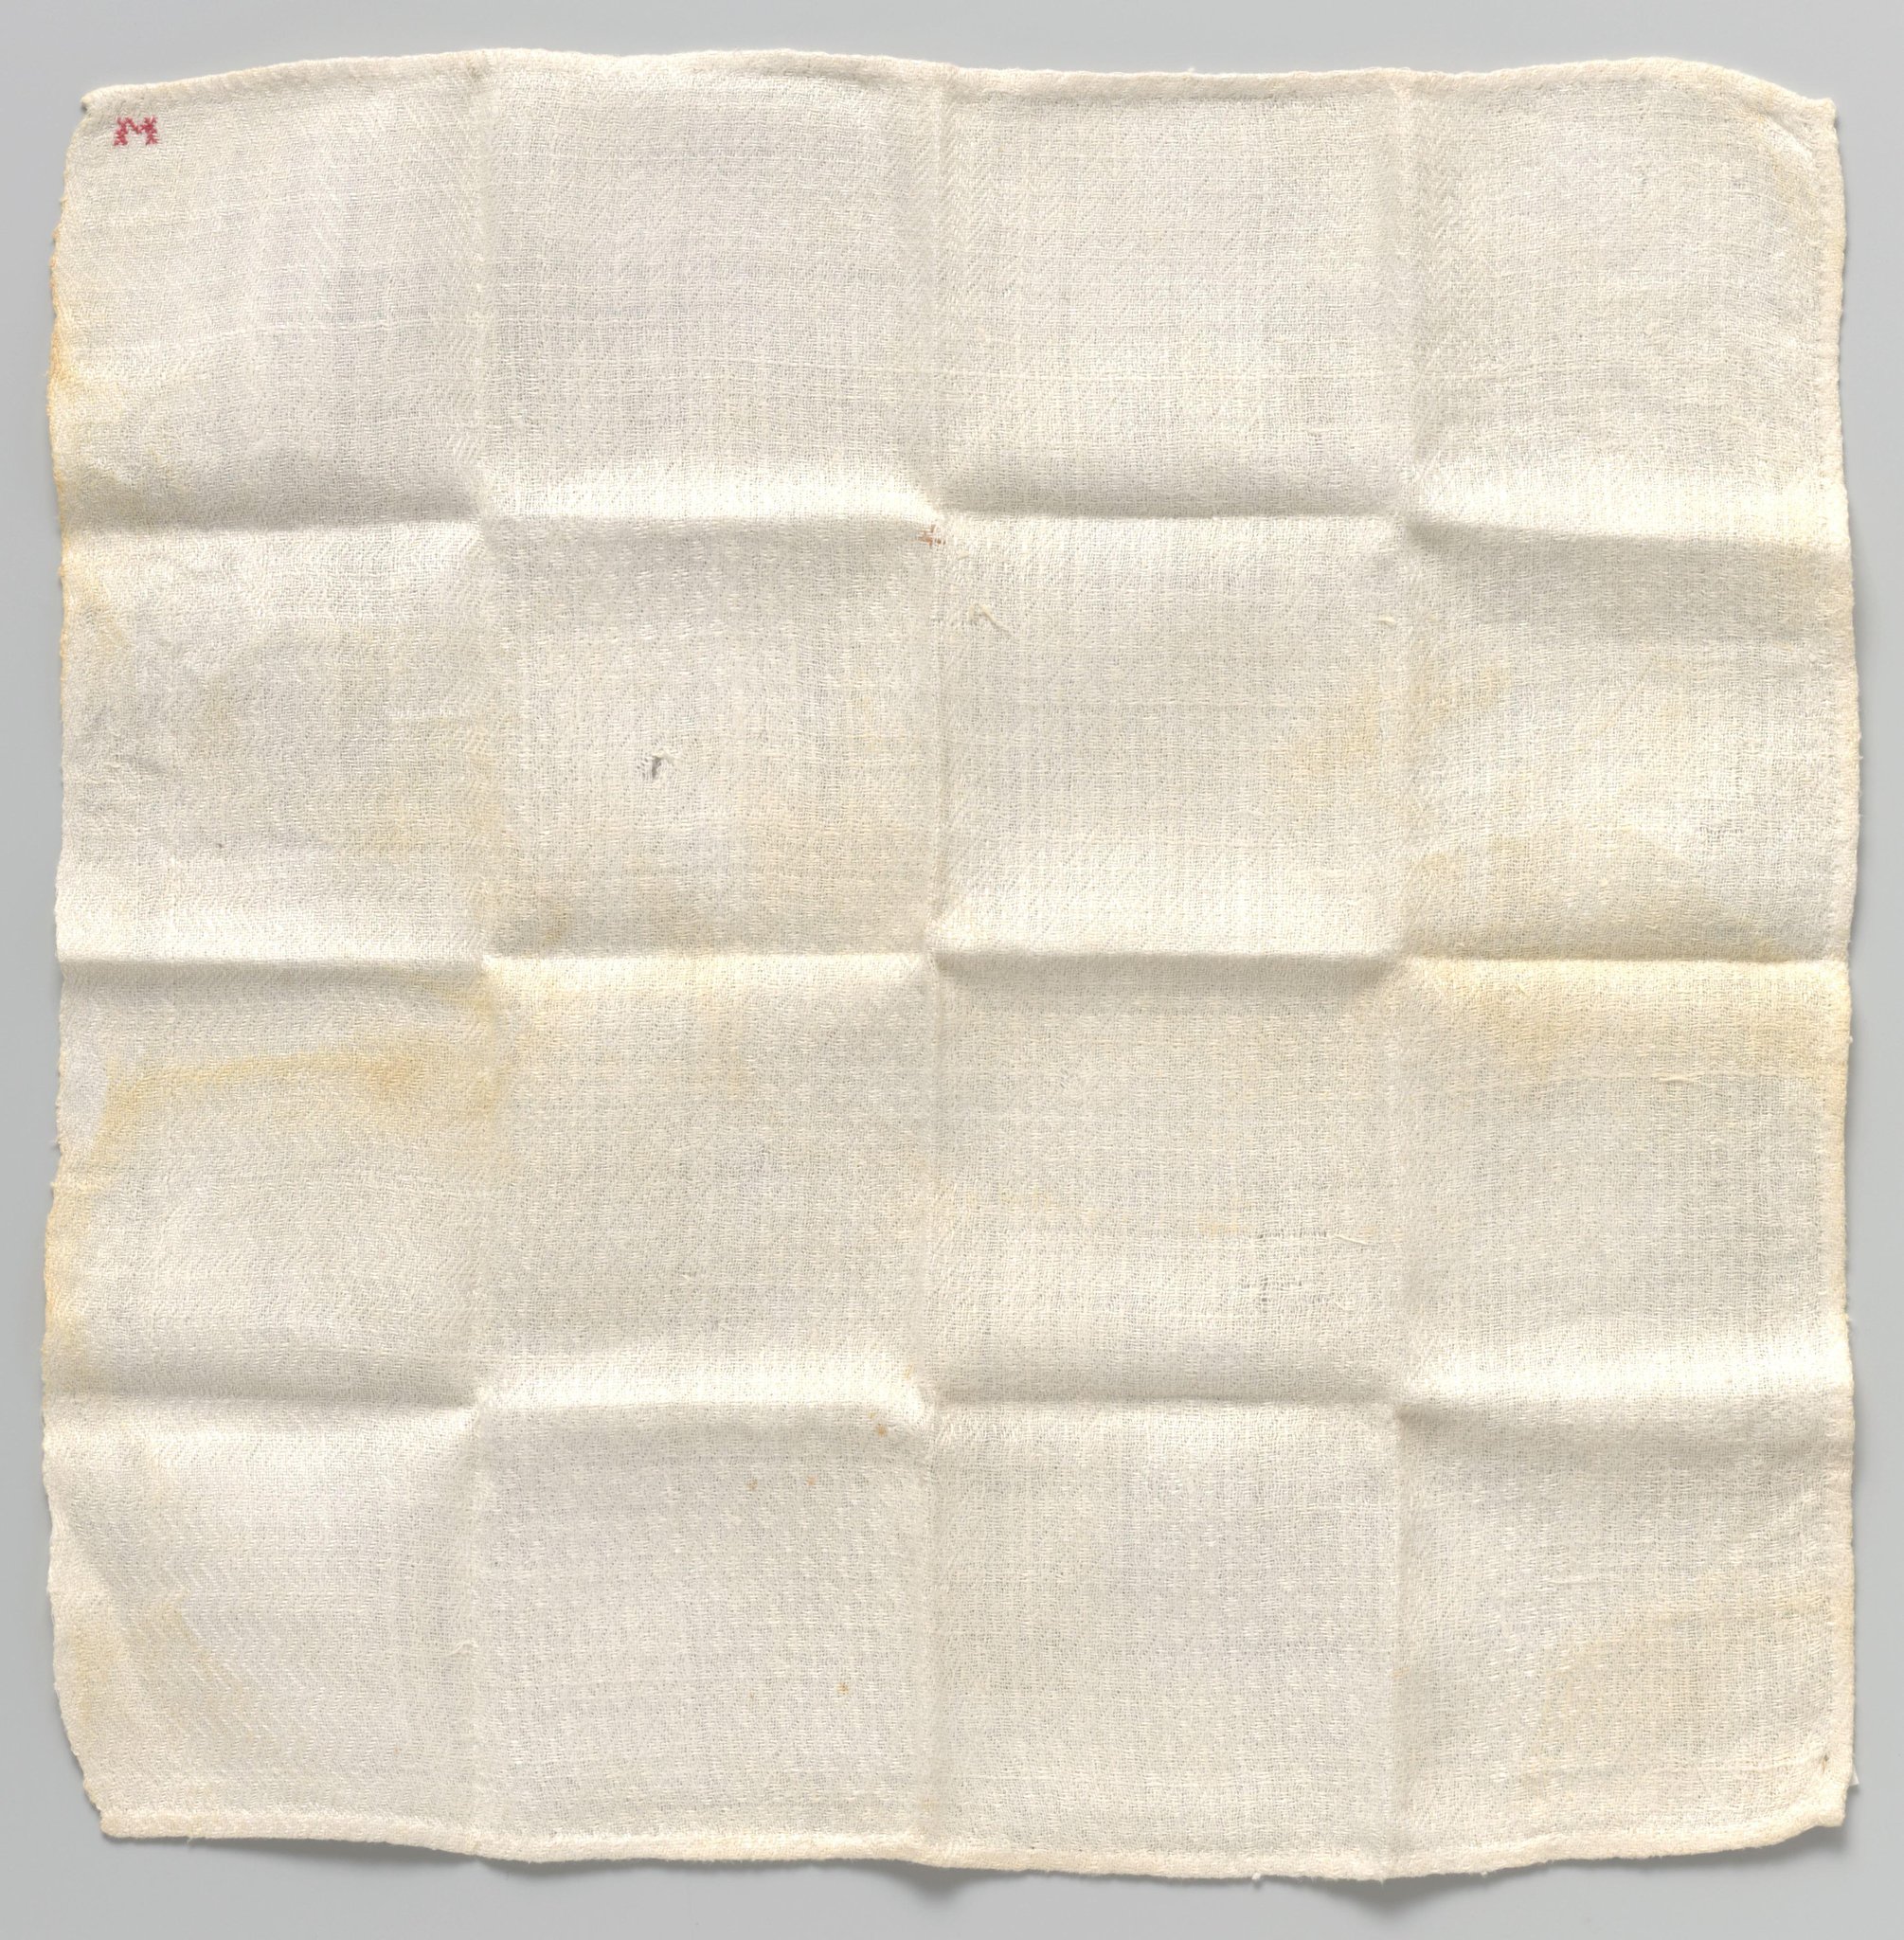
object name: napkin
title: Wit servet met ingeweven ruitjespatroon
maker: Anonymous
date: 1800-1930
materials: textile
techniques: weave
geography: europe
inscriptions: monogram: ‘M’